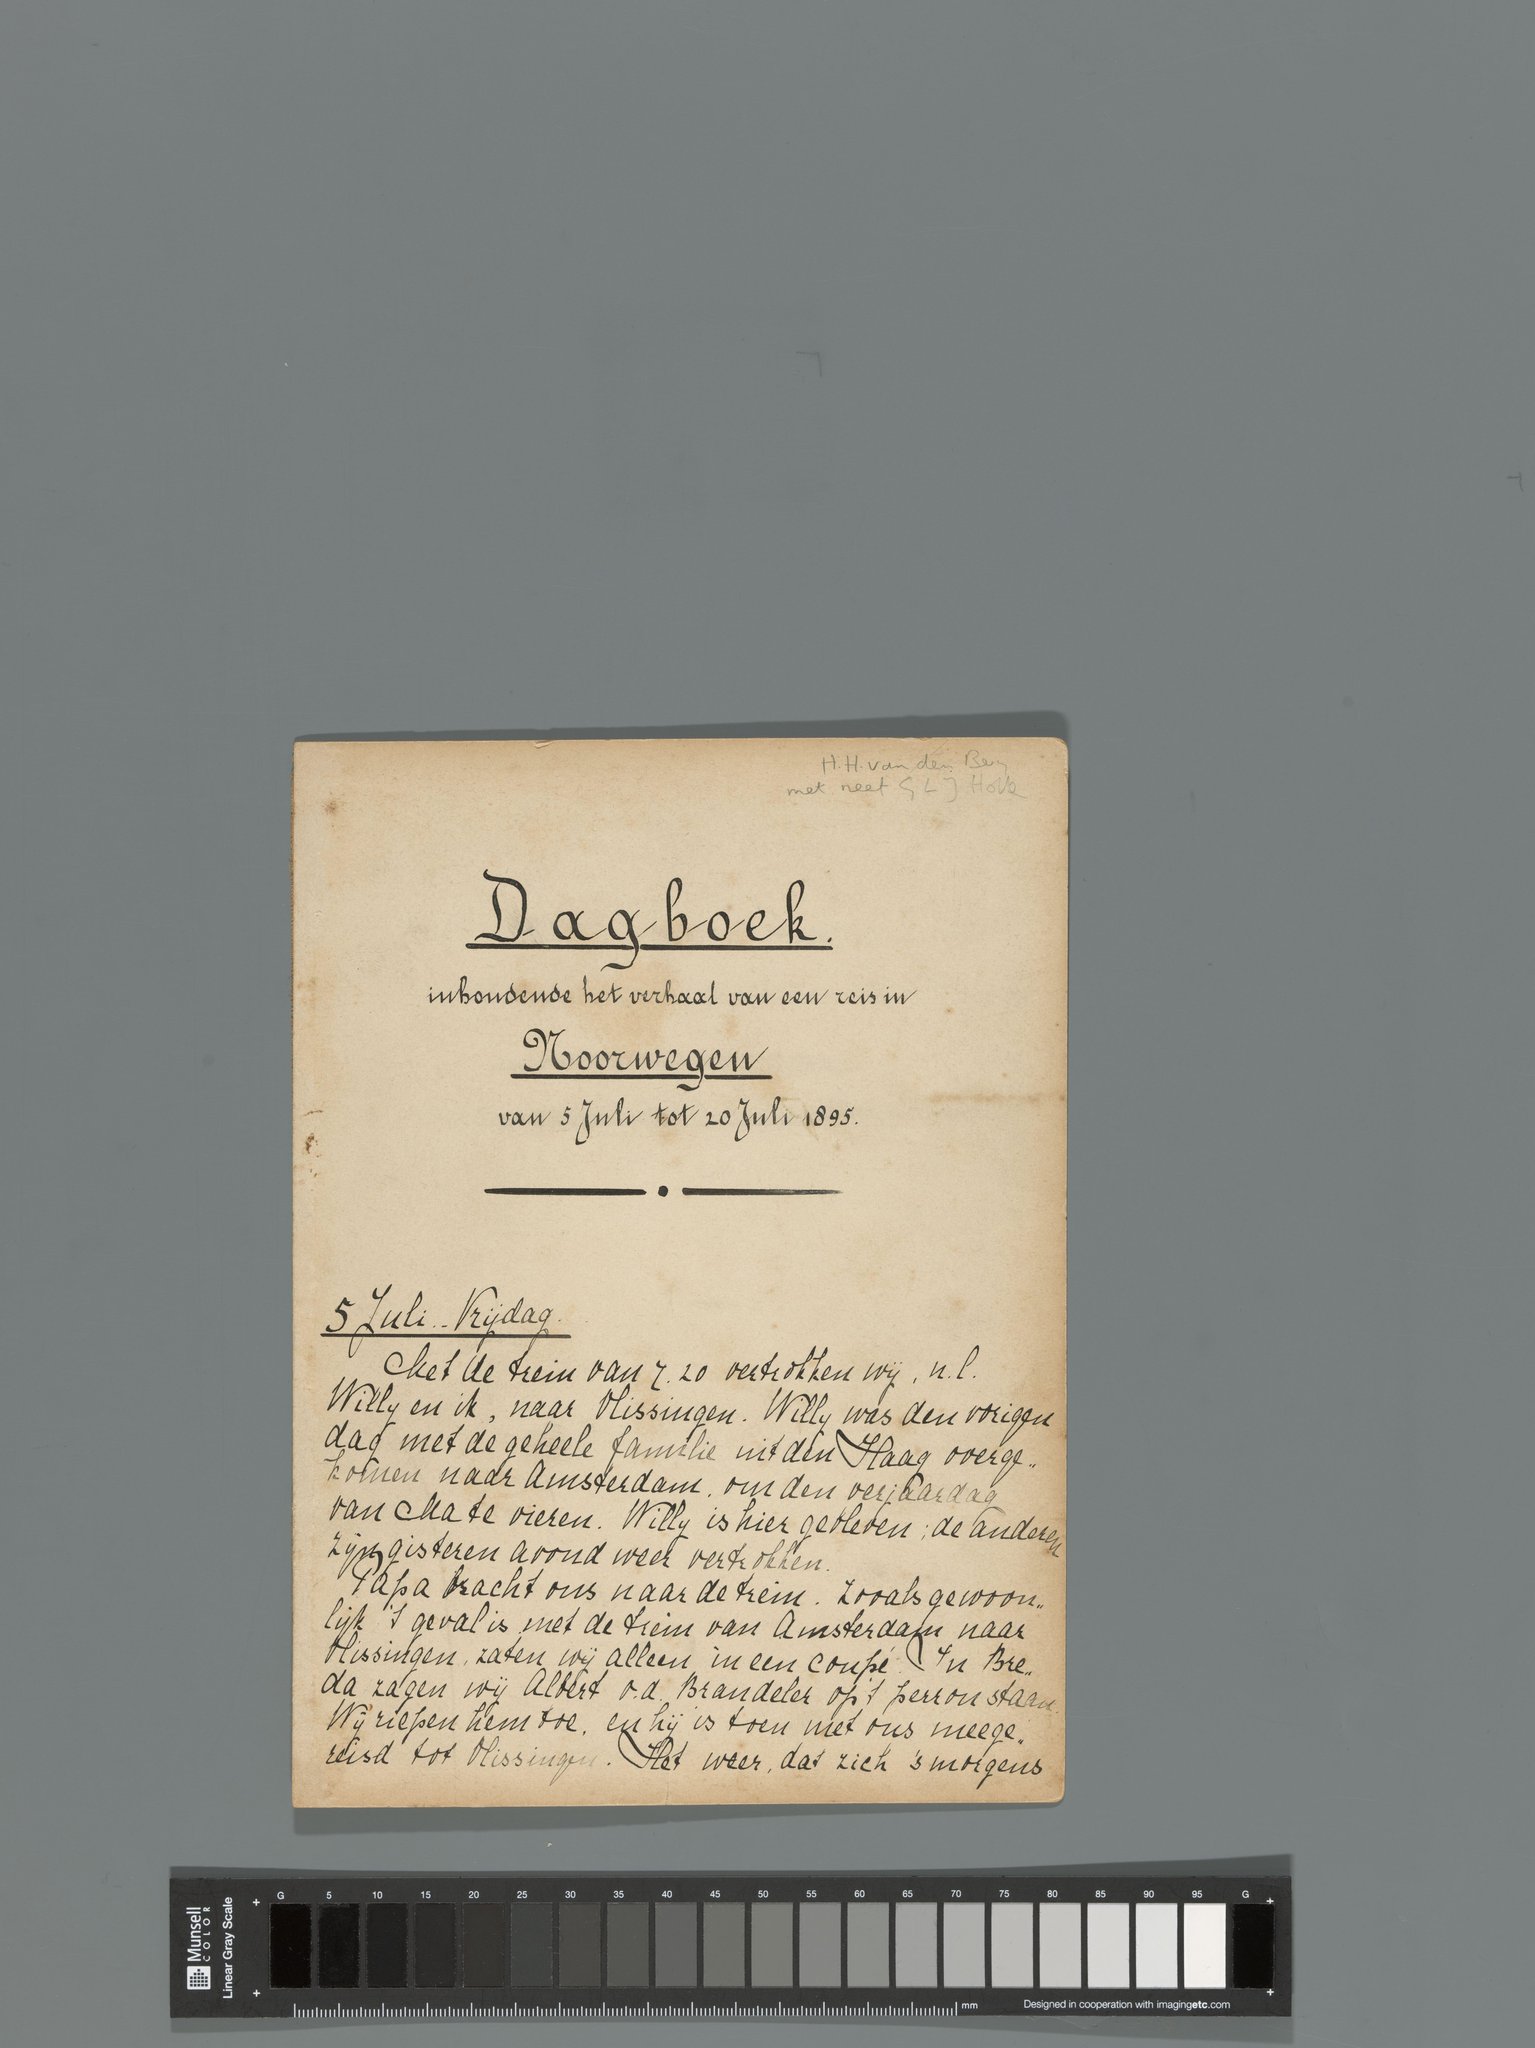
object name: page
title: Eerste pagina van een dagboek van een reis door Noorwegen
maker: hendrik herman van den berg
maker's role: amateurfotograaf, jurist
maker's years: 1875-1944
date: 1895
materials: ink, paper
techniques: pen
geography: norway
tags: batavia, amsterdam, hendrik herman van den berg, handwriting, written text, 'en route', traveller under way, norway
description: Eerste pagina van een dagboek met het verslag van een reis door Noorwegen gemaakt door Hendrik Herman van den Berg en zijn neef Guillaume Louis Jacques Holle tussen 5 en 20 juli 1895.